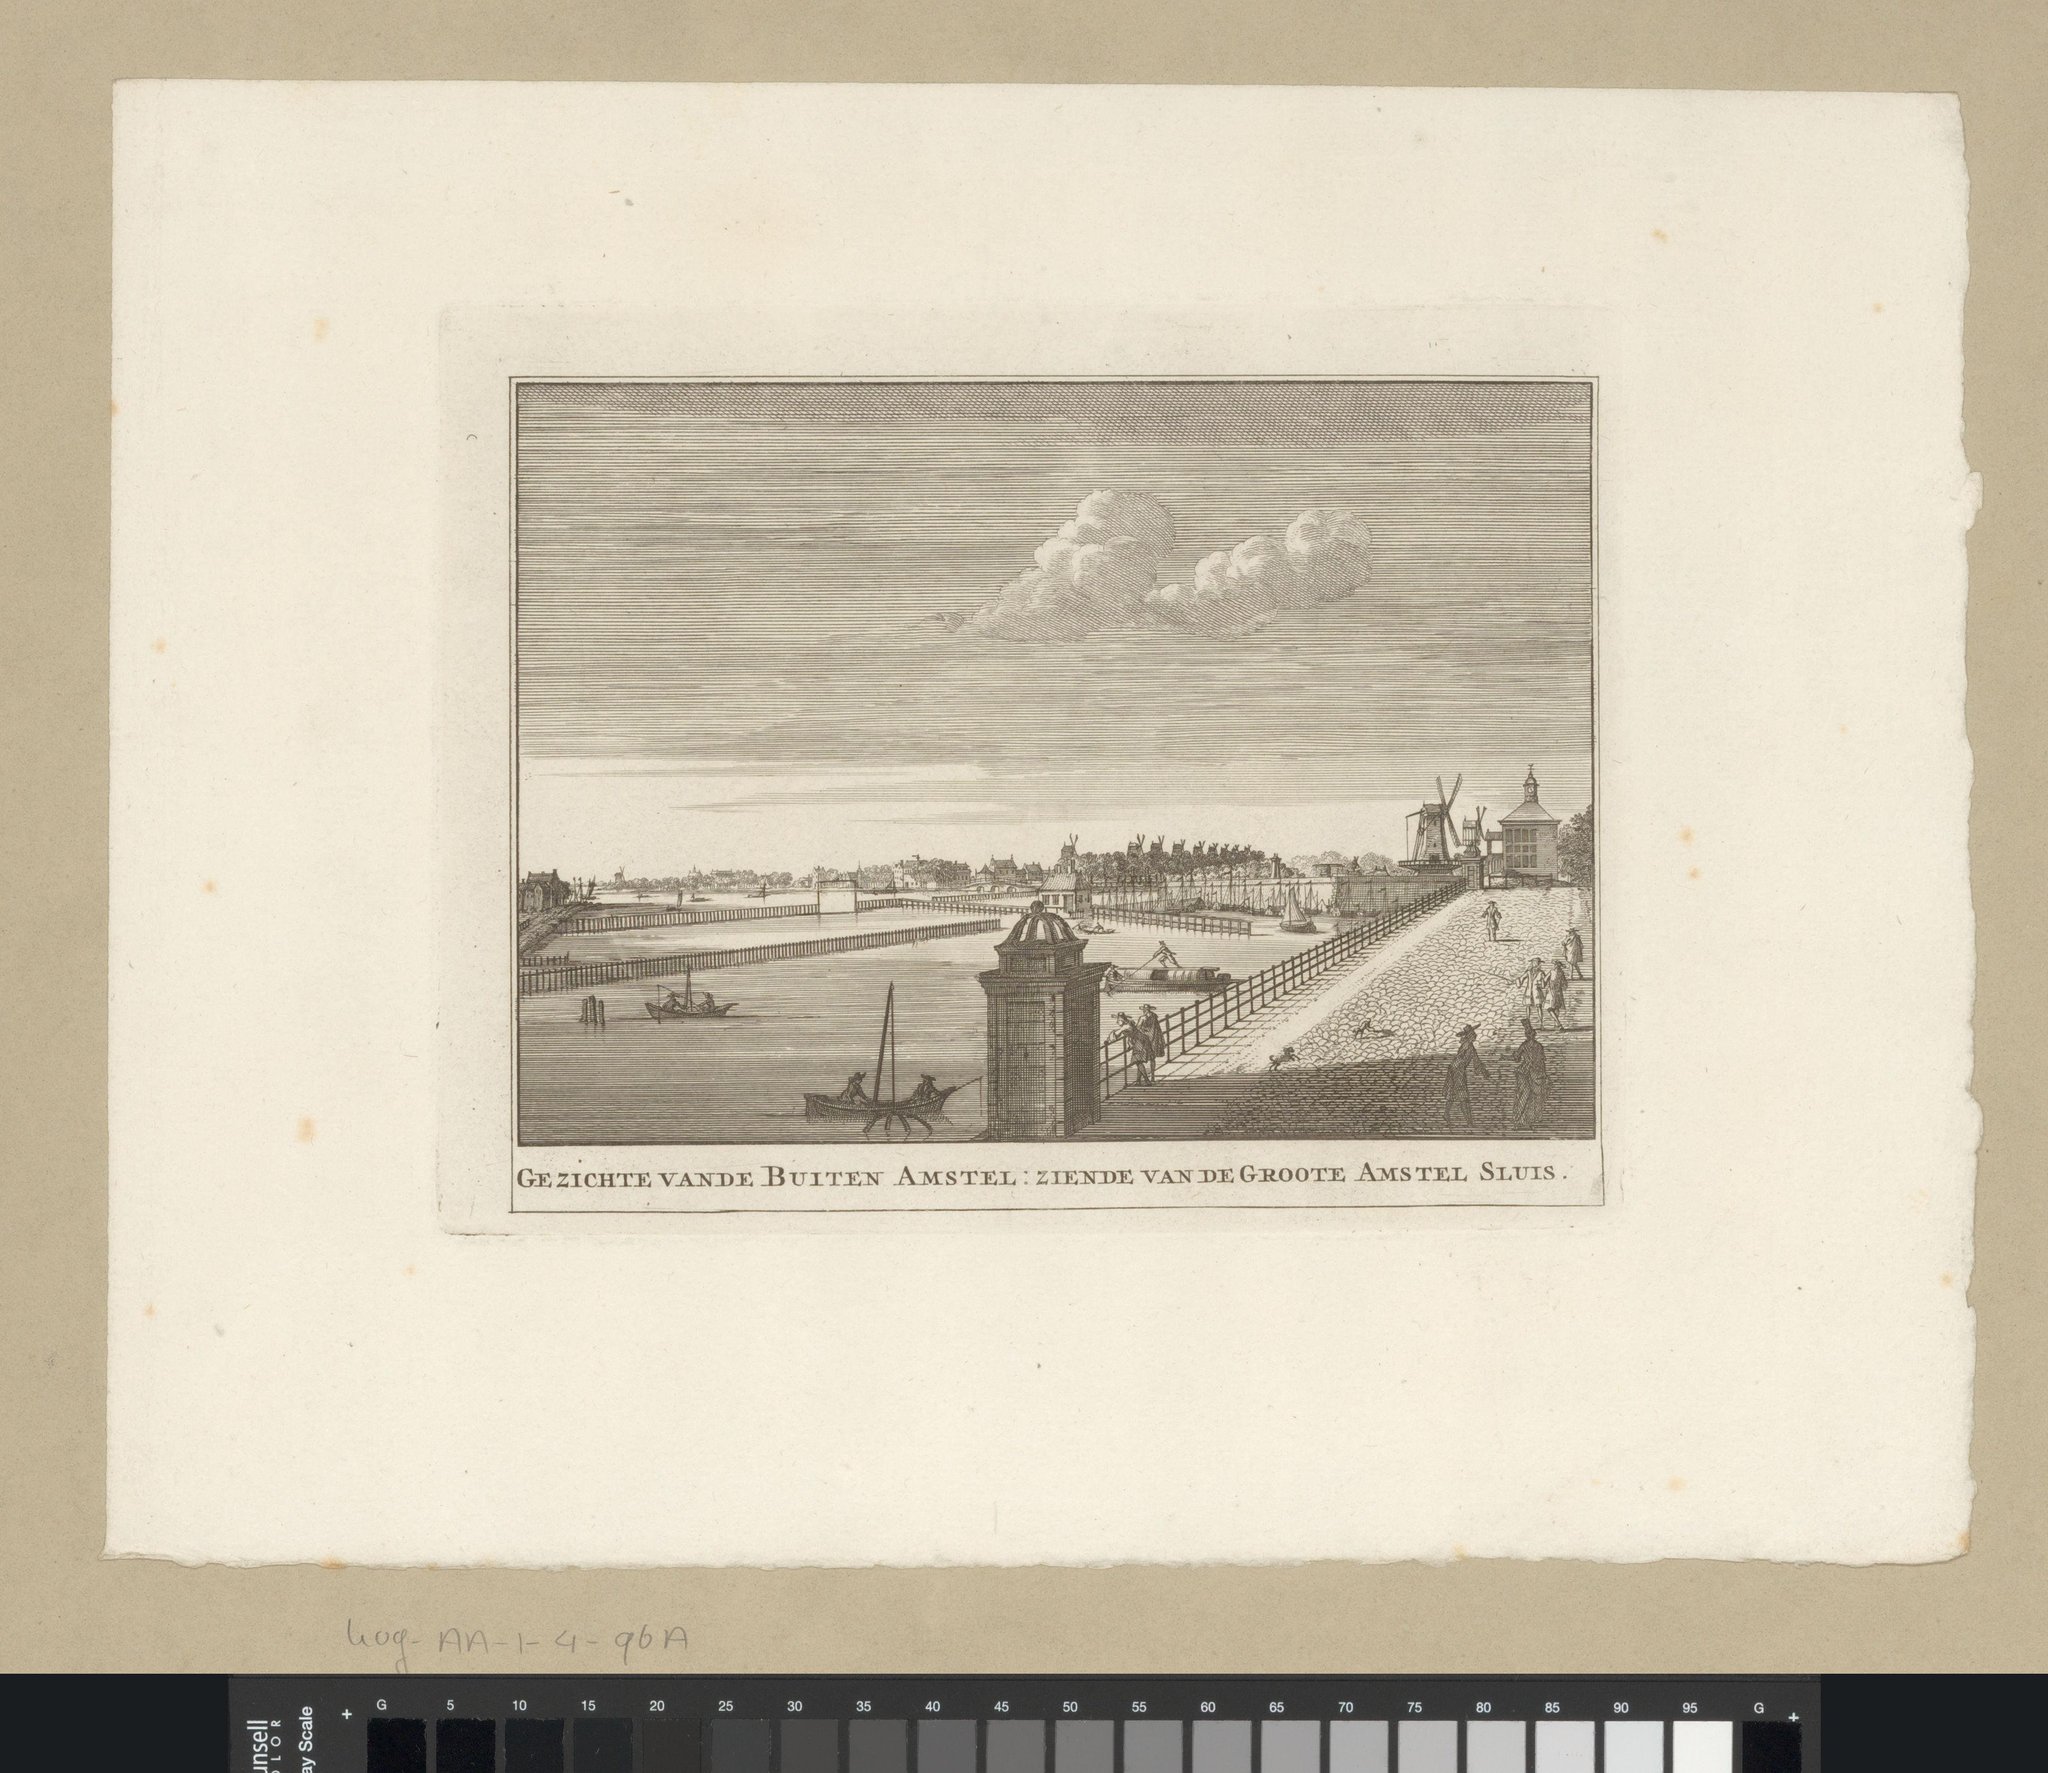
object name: print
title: Gezichte van de Buiten-Amstel: ziende van de Groote Amstel Sluis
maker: Anonymous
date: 1700-1750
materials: paper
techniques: etching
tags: city-view in general; 'veduta', river, windmill in landscape, bridge in city across river, canal, etc.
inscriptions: collector's mark: ‘4’ Lugt 1641b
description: Onderwerpsrubriek binnen de Atlas Amsterdam: Amstel van Hogesluis stroomopwaarts.